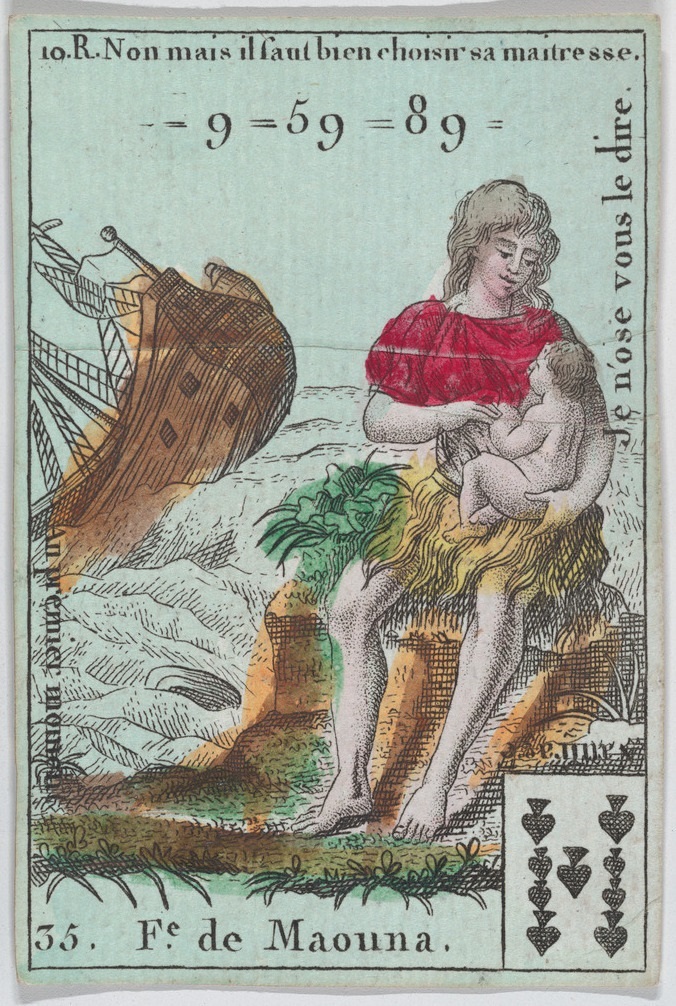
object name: print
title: F.e de Maouna from playing cards "Jeu d'Or"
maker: anonymous, french, 18th century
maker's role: artist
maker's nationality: french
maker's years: 1700-1800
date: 1700-1799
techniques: etching, hand coloring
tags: infants,women,playing cards,ships